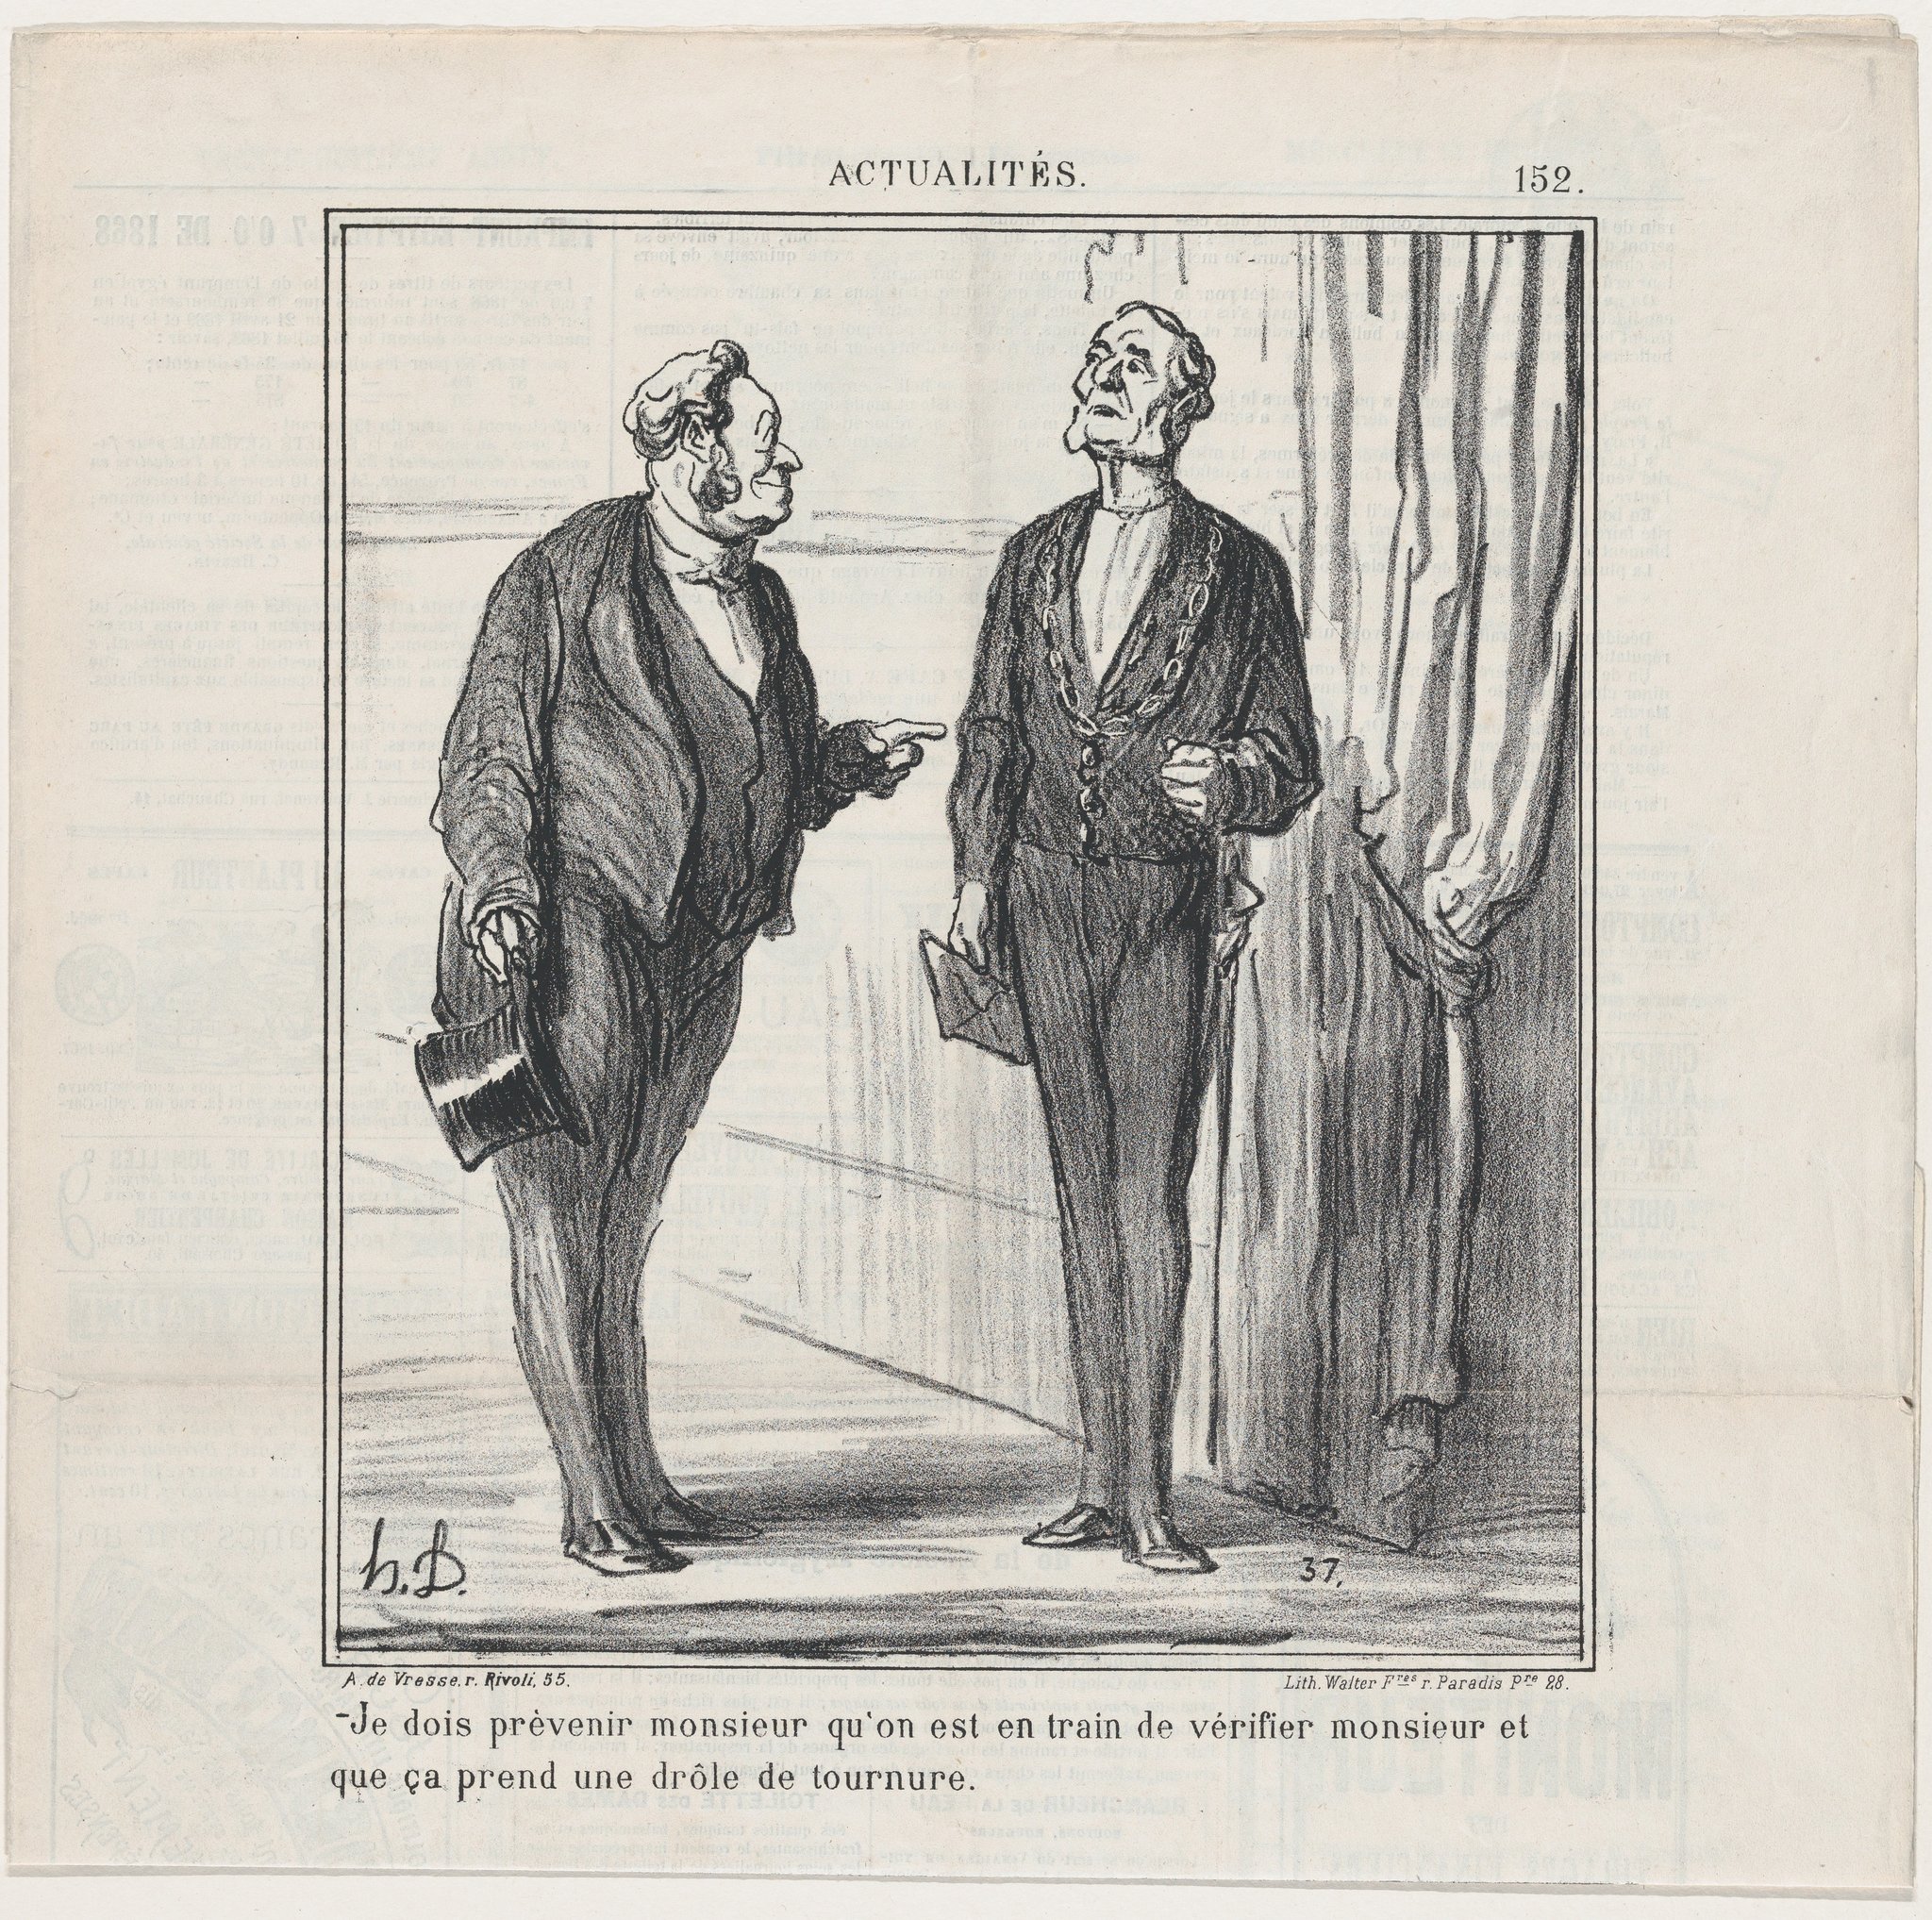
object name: print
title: Monsieur, I am bound to advise you that they are in the process of verifying Monsieur and that this seems to be taking a curious turn, from "News of the day"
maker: honoré daumier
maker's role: artist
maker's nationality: french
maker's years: 1808-1879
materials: paper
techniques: lithograph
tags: men